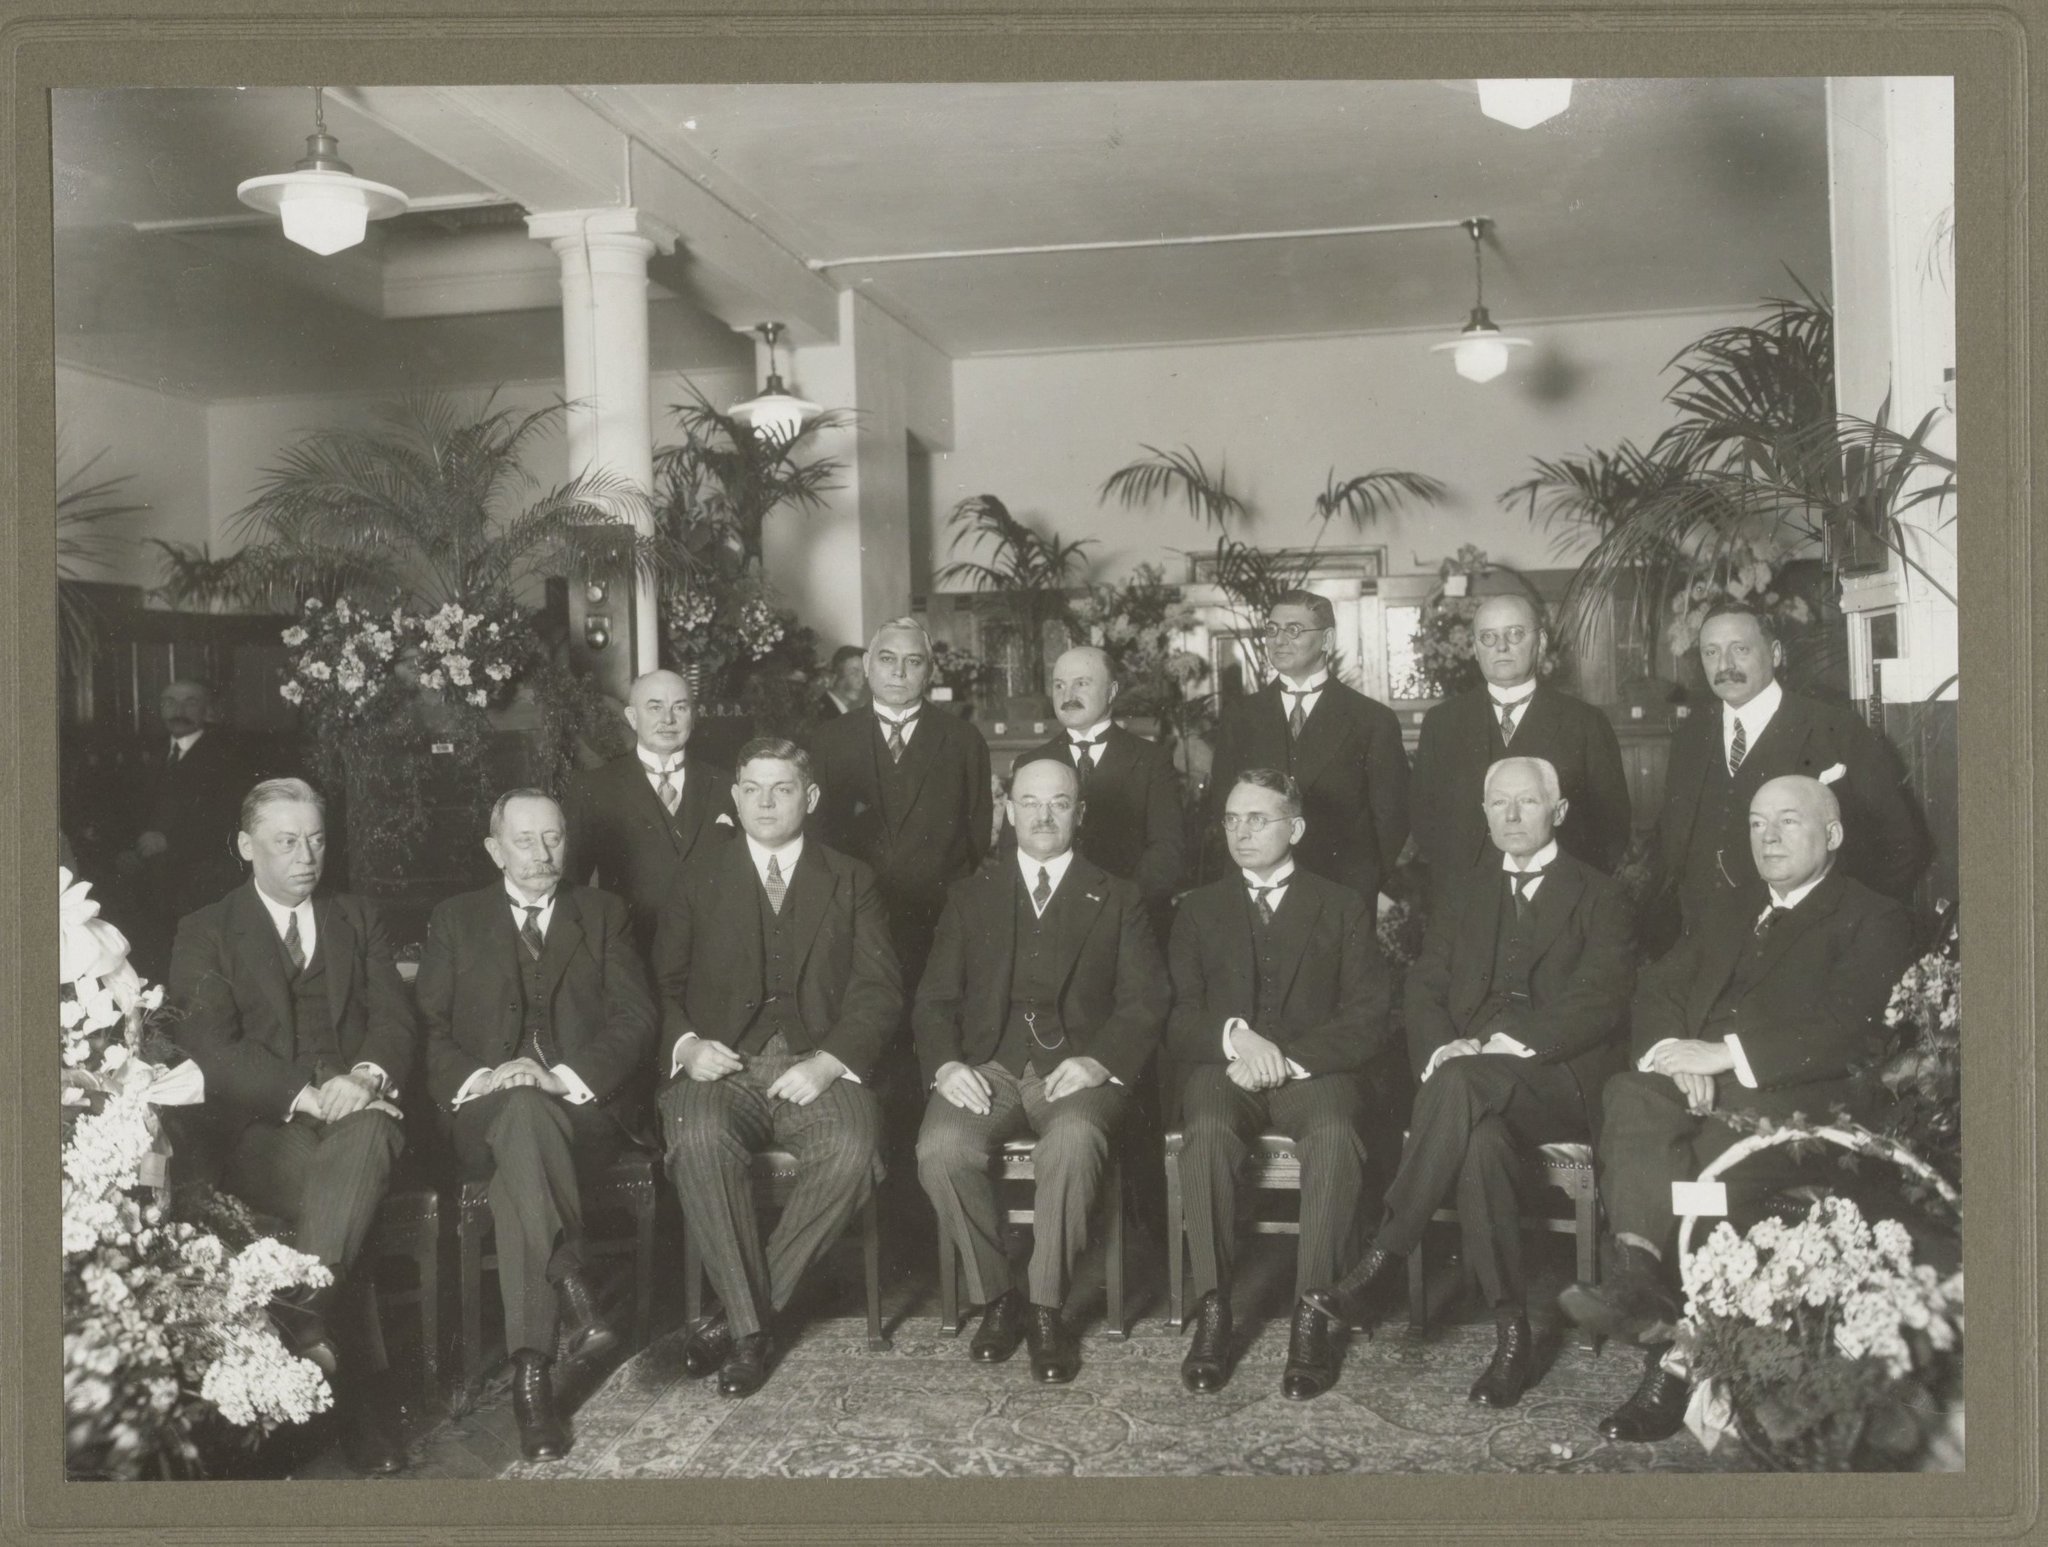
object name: photograph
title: Directie van de Handelsvereniging Amsterdam (HVA)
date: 1929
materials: photographic support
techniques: gelatin silver print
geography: amsterdam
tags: colonial system, trade-company, director, boss (in modern industry), anonymous historical persons portrayed in a group, in a group-portrait, dutch east indies, the, amsterdam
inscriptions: inscription: ‘58377’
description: Groepsfoto van de leden van de directie van de Handelsvereniging Amsterdam. Foto in het fotoalbum van de viering van het 50-jarig jubileum van de Handelsvereniging Amsterdam (HVA) in 1929.